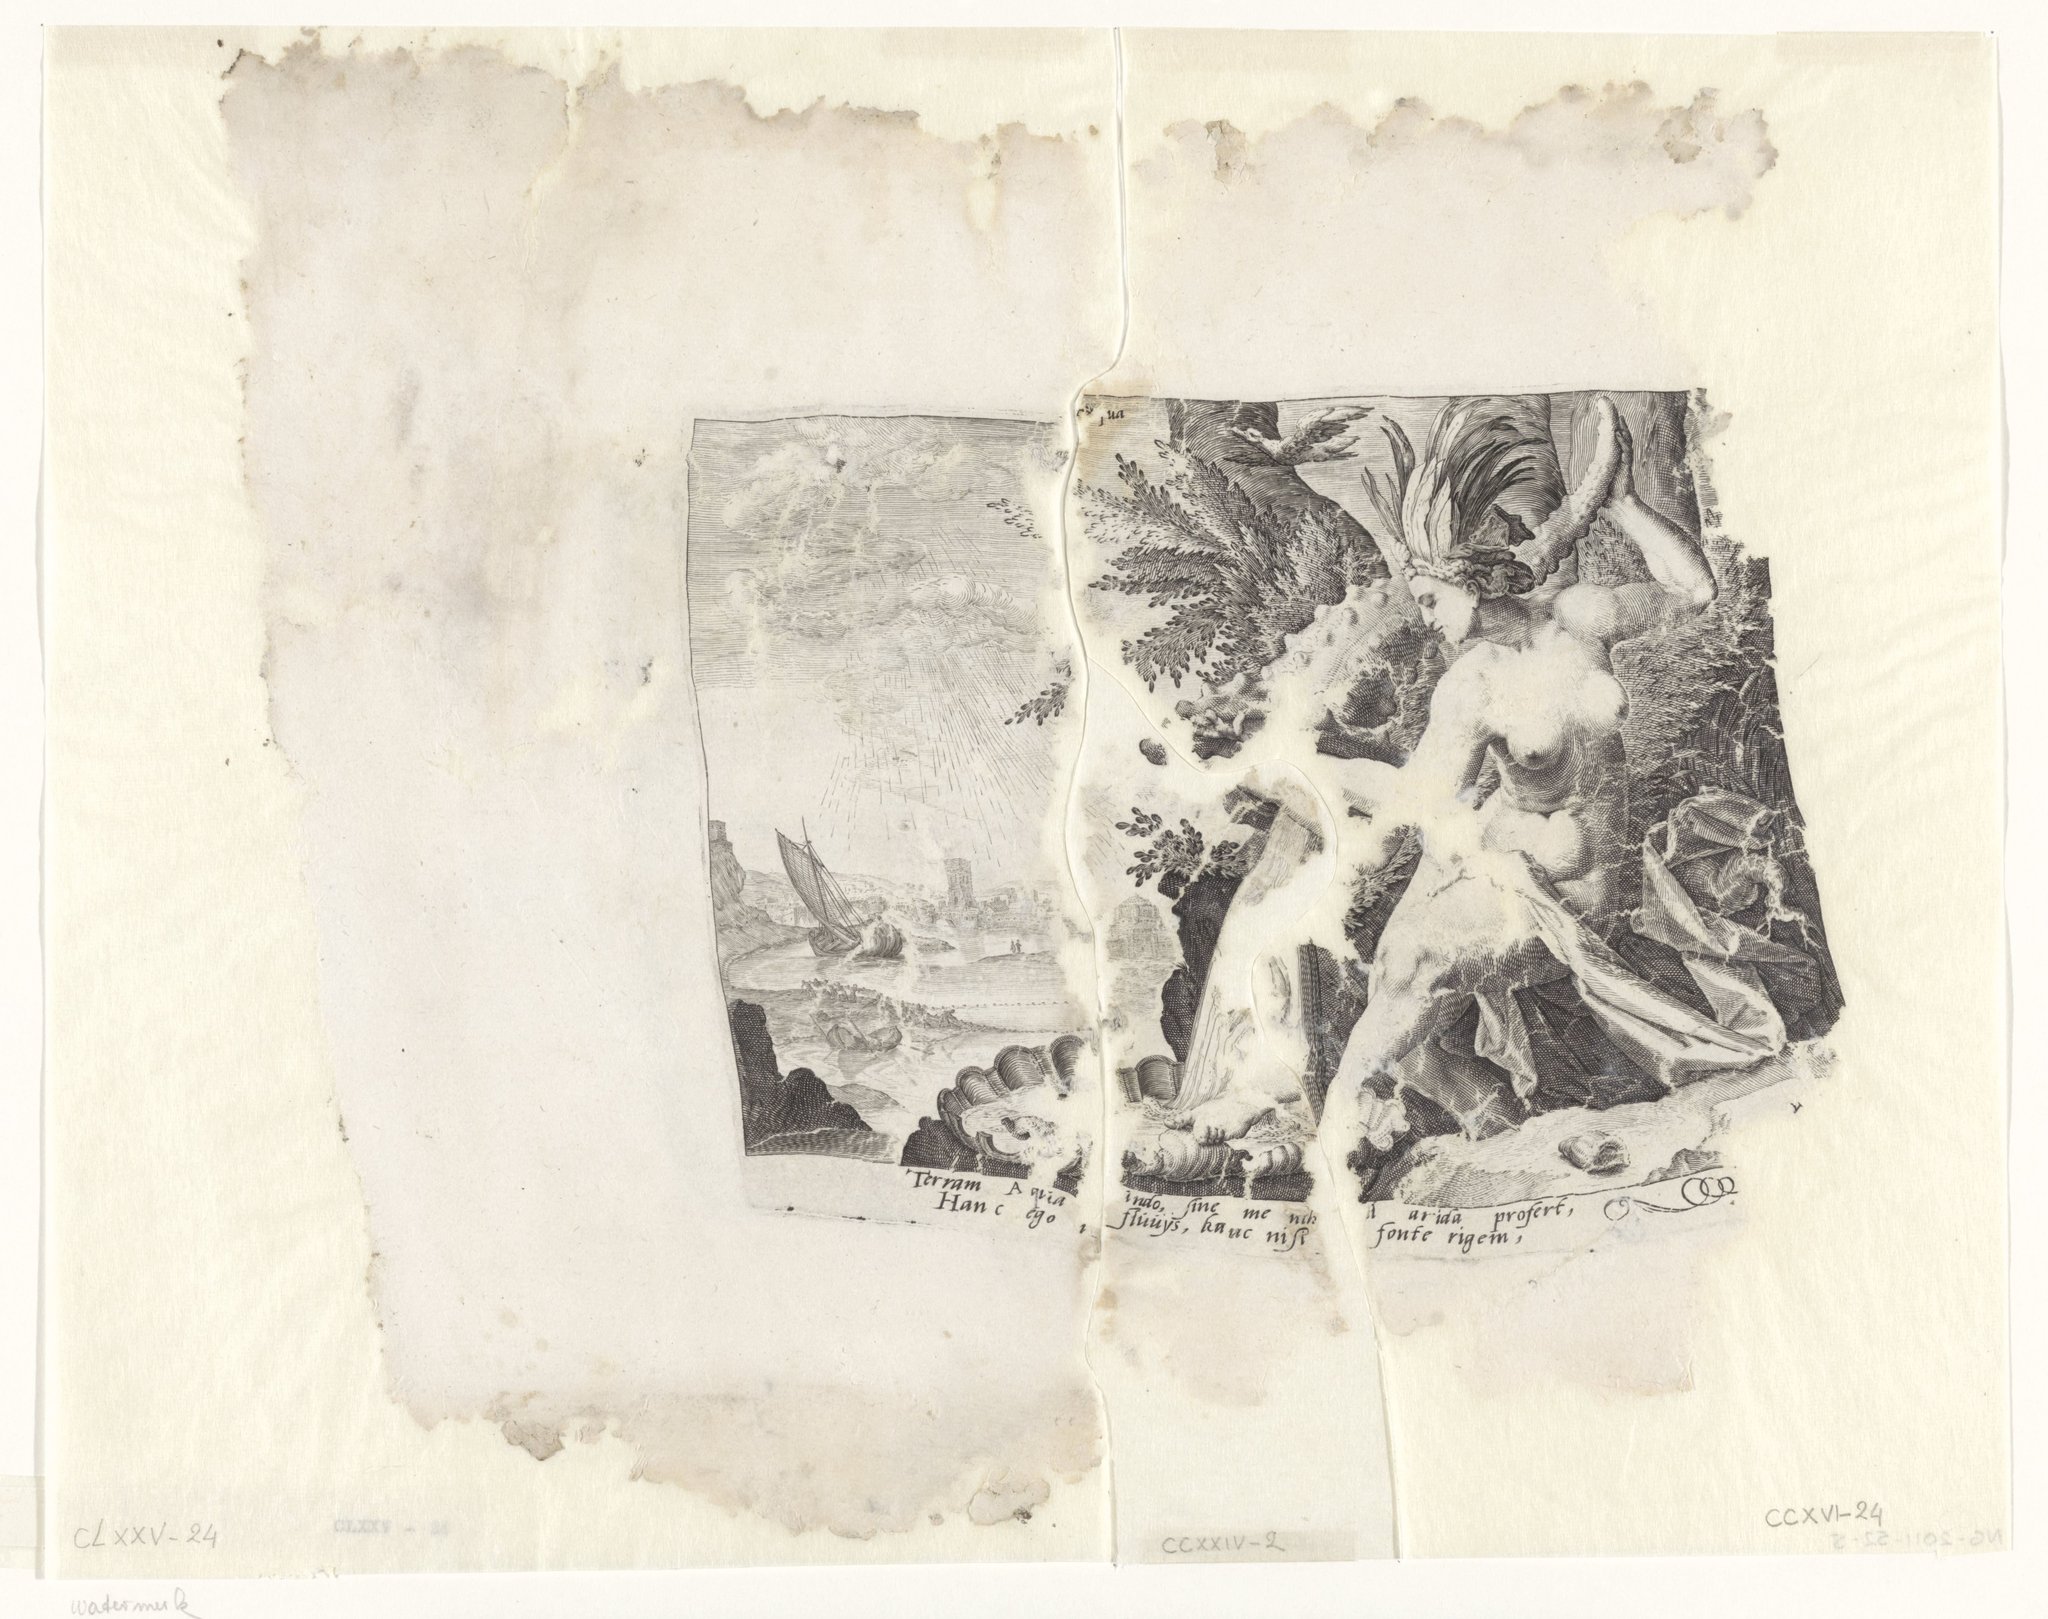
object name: print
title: Aqua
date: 1580-1596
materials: paper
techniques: engraving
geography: amsterdam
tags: water (one of the four elements)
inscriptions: watermark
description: De prenten in de Nova Zembla collectie zijn tijdens een expeditie van Willem Barendsz en Jacob van Heemskerk in 1596-1597 noodgedwongen in het winterkamp, het ‘Behouden Huis’, op het eiland achtergelaten. De prenten waren in één of meerdere stapels als handelswaar meegenomen vanuit Amsterdam. Bijna drie eeuwen later, in 1871, keerde de Noor Elling Carlsen terug naar Nova Zembla en vond daar de restanten van het ‘Behouden Huis, inclusief een groot deel van de inventaris. Een deel van de prenten, in de vorm van aaneengekoekte kluiten, werd toen ook teruggevonden. De papierkluiten waren soms op meerdere plekken gebroken. Tussen 1975-1979 zijn de prenten van elkaar gescheiden. Dit leverde in totaal ca. 1000 fragmenten van ca. 400 afdrukken van ca. 150 verschillende prenten op. Voor zover mogelijk zijn de fragmenten samengevoegd en zijn de prenten gereconstrueerd.